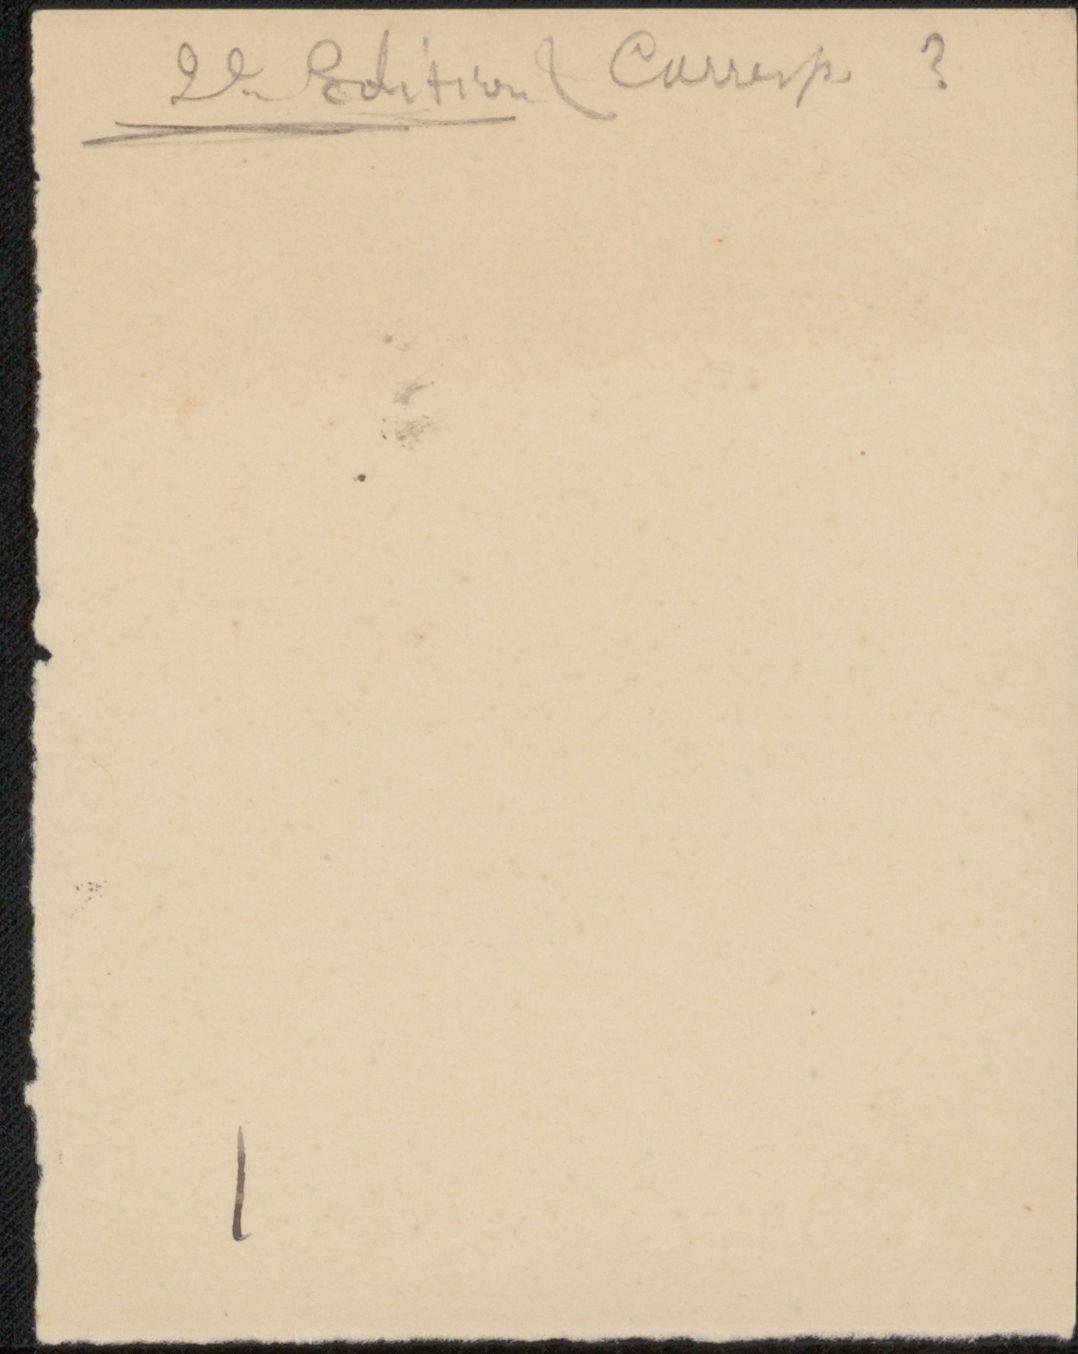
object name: aantekening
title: Aantekening uit archief Philip Zilcken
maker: philip zilcken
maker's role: draughtsman, painter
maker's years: 1857-1930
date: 1867-1930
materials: paper, pencil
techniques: writing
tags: the hague, painter, draughtsman, philip zilcken